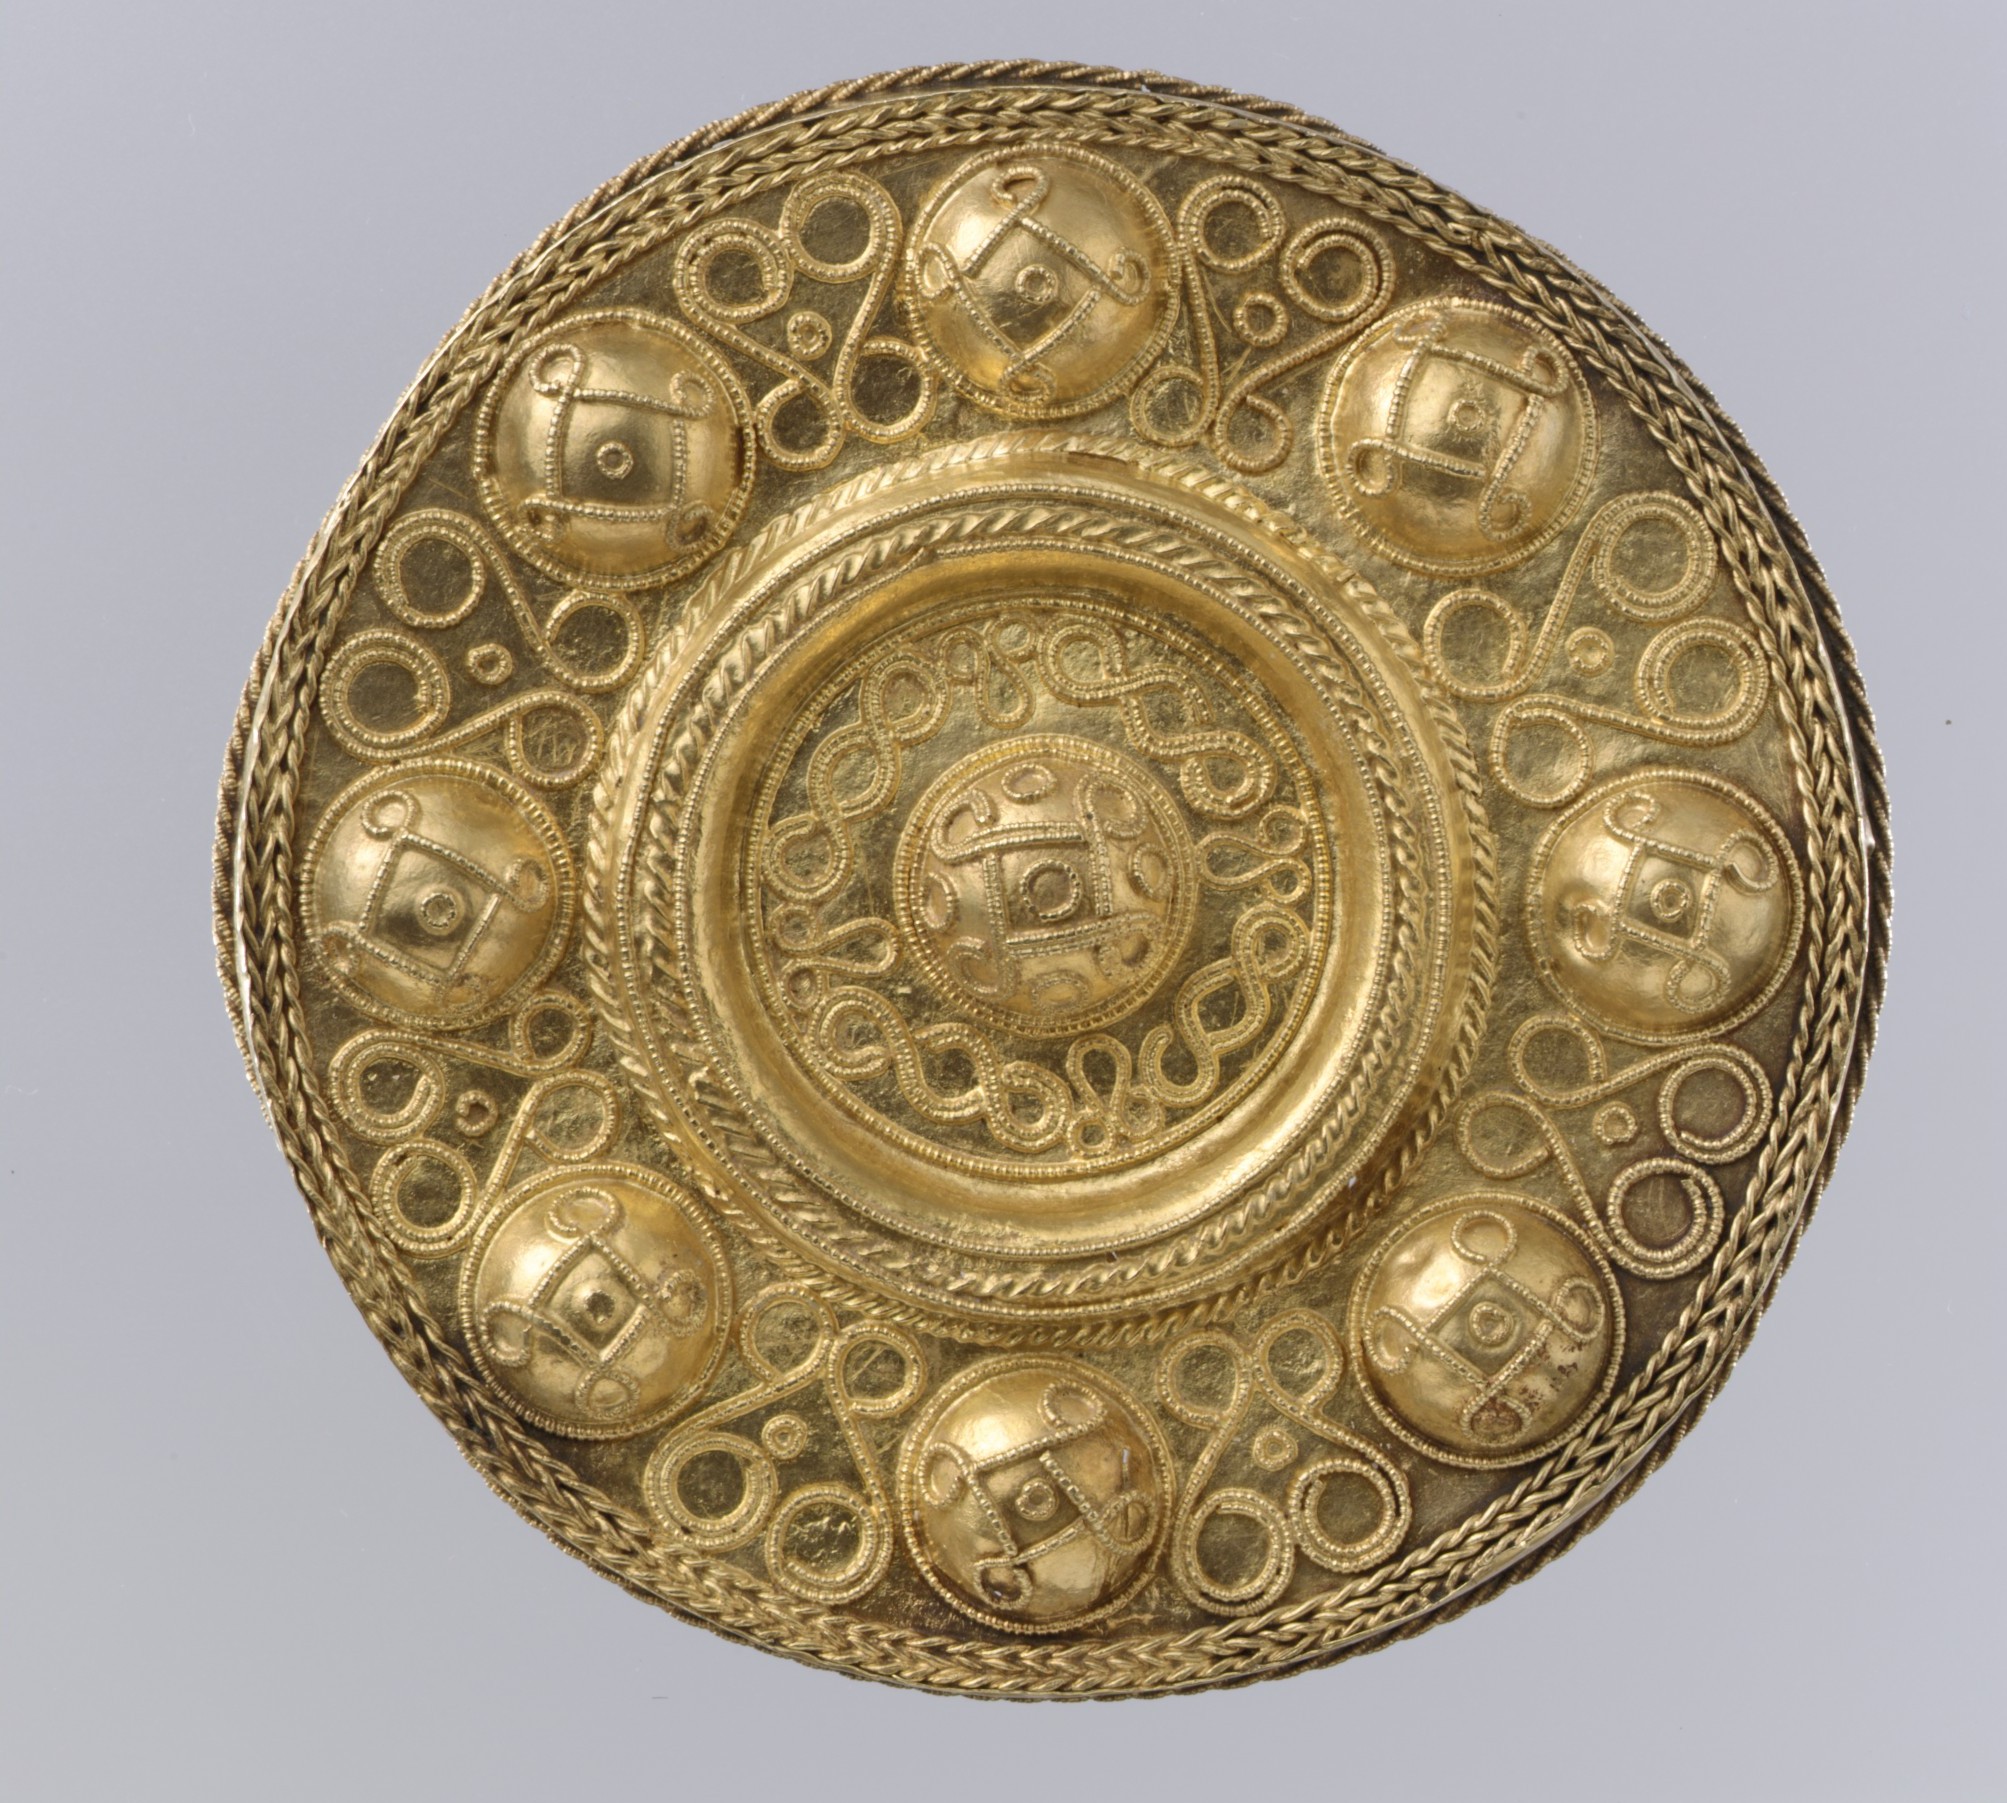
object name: brooch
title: Disk Brooch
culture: langobardic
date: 600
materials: gold, metal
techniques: filigree, repoussé